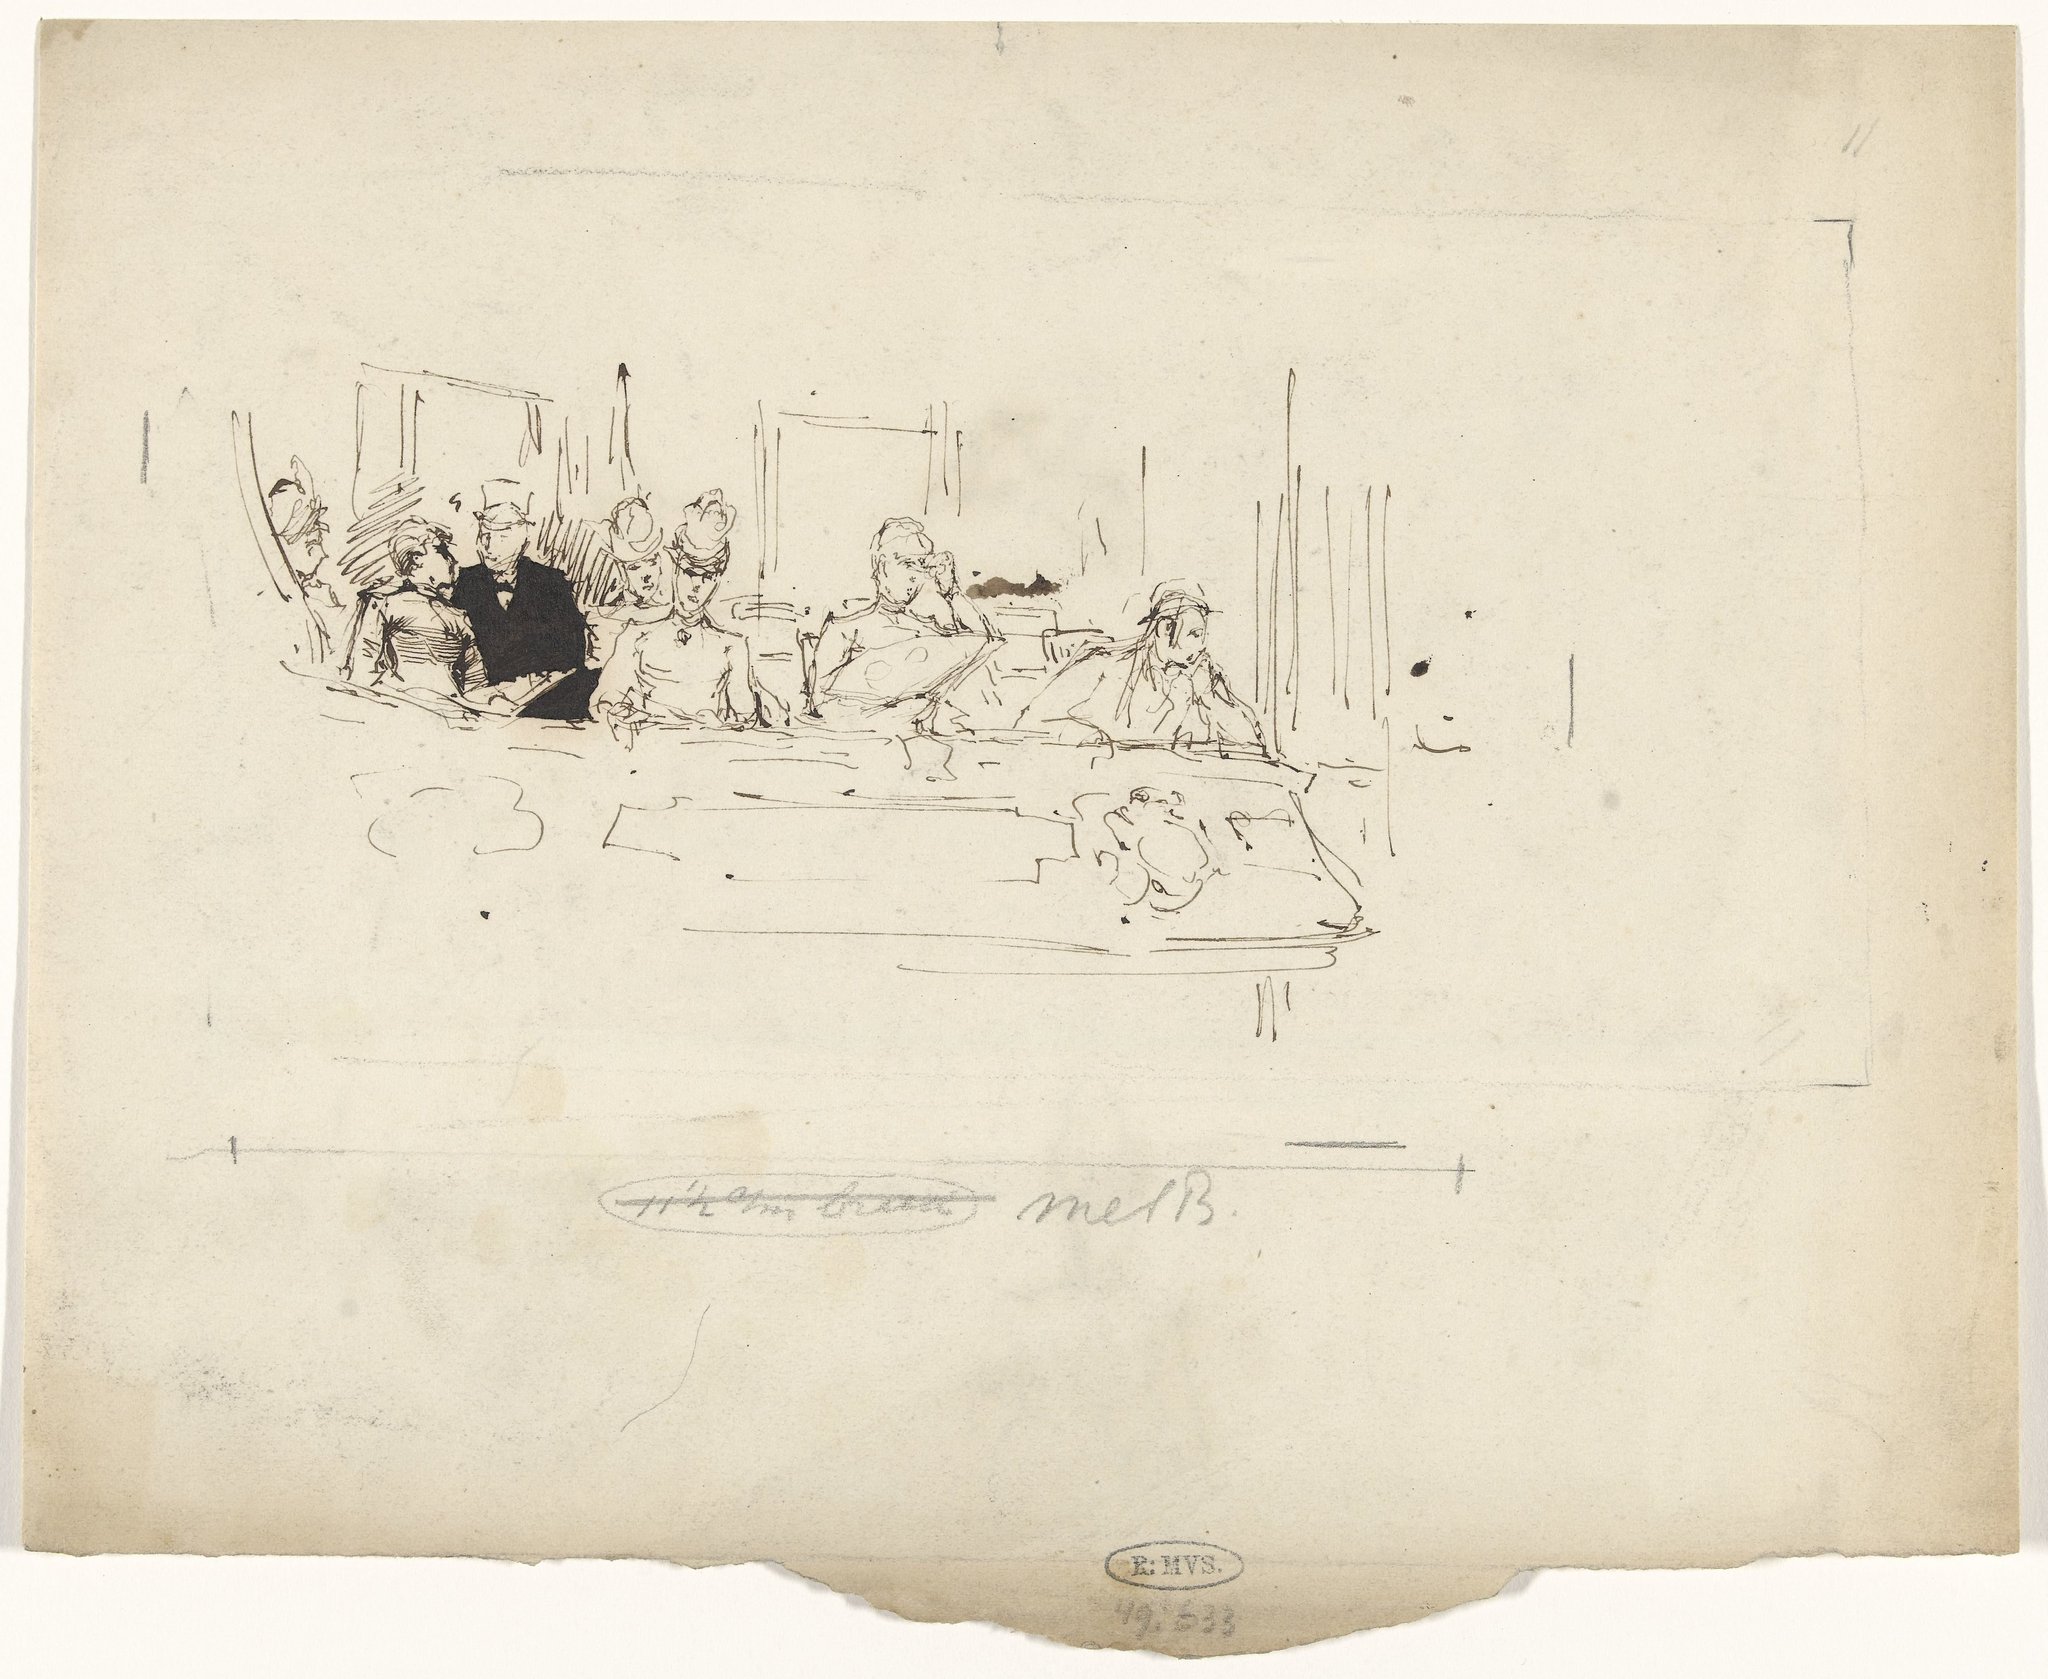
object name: drawing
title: Toeschouwers op het balkon in de schouwburg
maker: marius bauer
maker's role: draughtsman, print maker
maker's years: 1867-1932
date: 1877-1932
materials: ink, paper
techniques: pen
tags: the audience ~ art performance